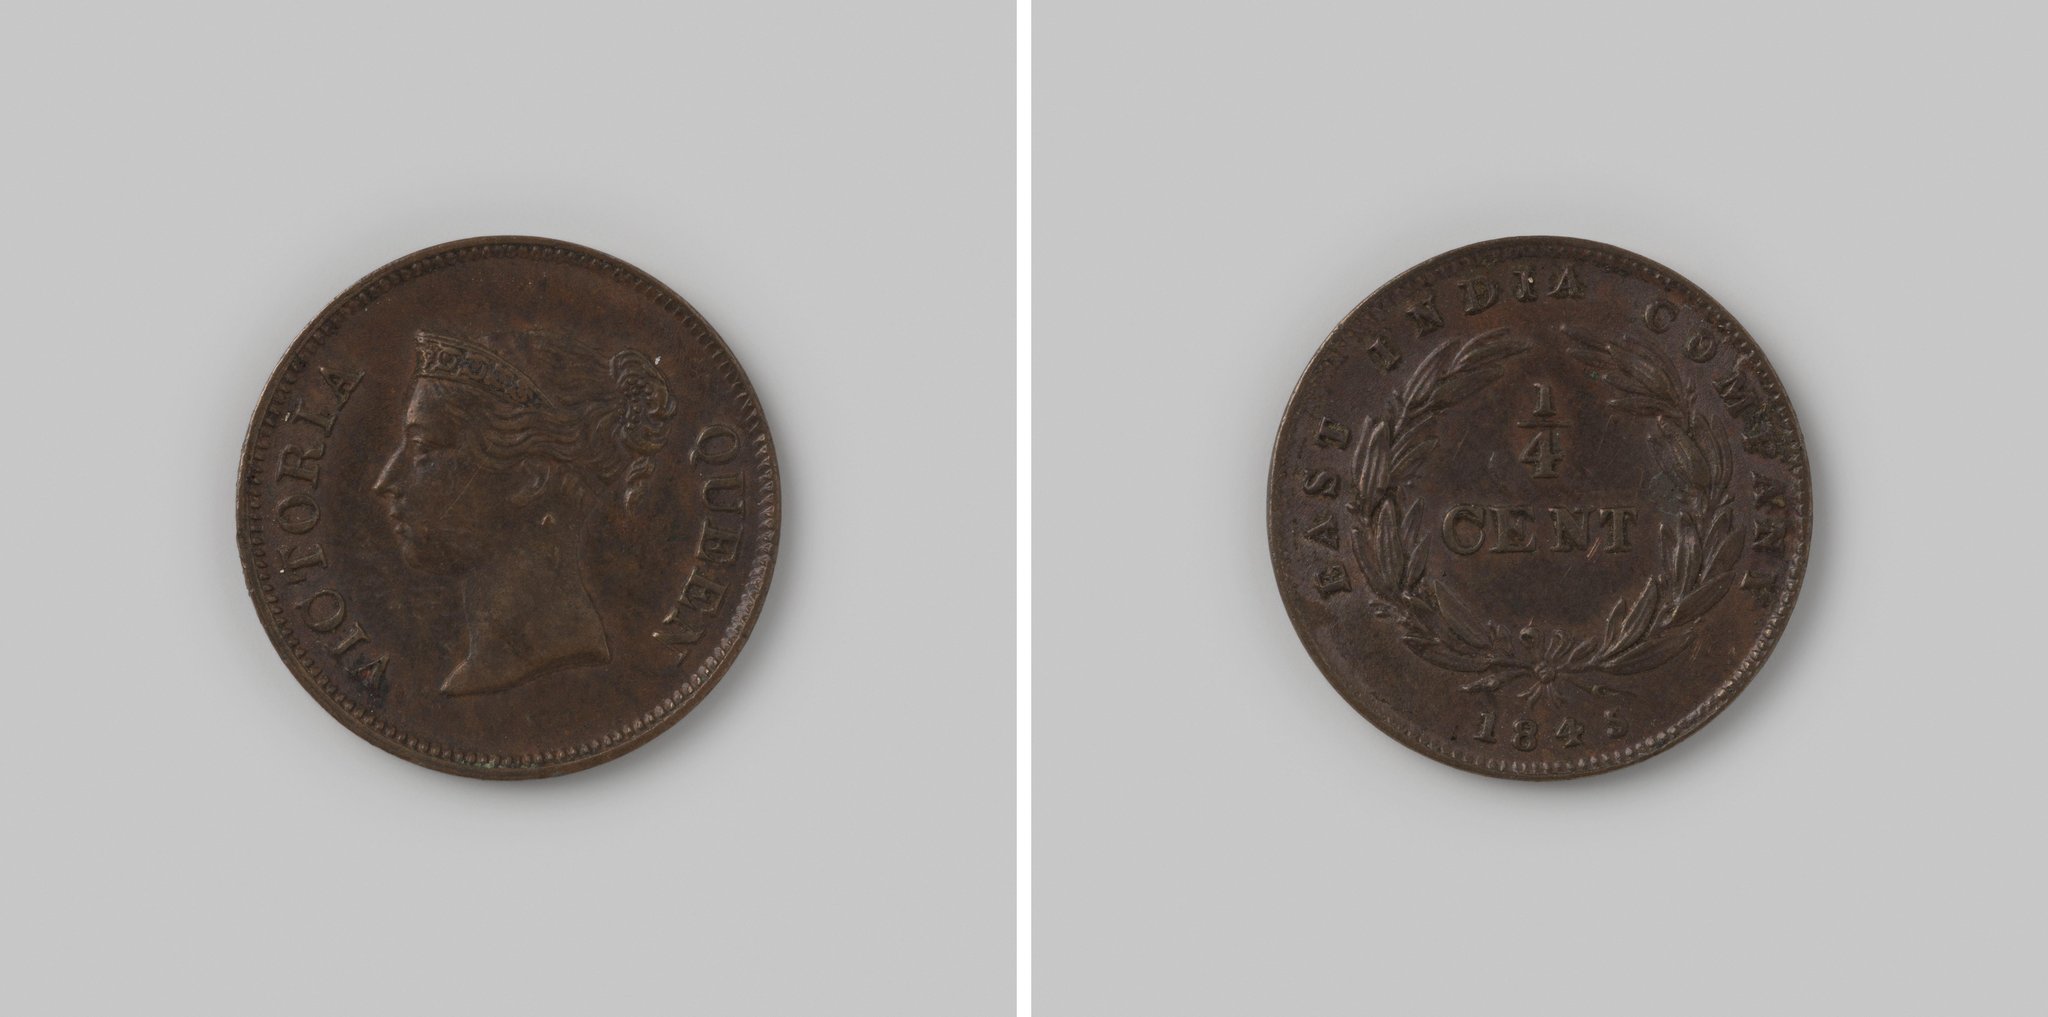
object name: coin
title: Koningin Victoria,Engelse, op naam van de Engelse Oostindische Compagnie (EIC), Straits Settlements, 1/4 cent, 1845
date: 1845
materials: copper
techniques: striking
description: Koperen munt. Voorzijde: gekroond hoofd van koningin Victoria naar links. Keerzijde: tussen twee samengebonden takken in twee regels waarde-aanduiding: 1/4 cent. Als omschrift: East India Company met onderaan jaartal. Gladde rand.